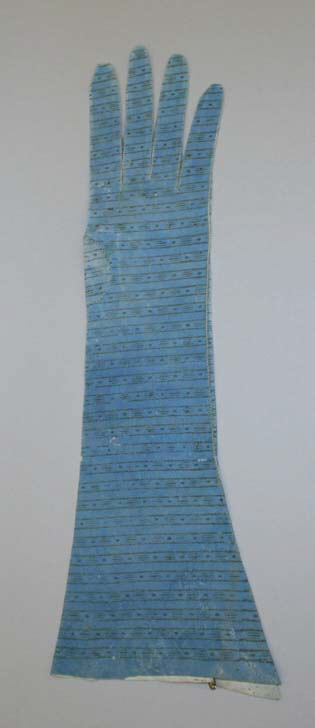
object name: glove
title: Gloves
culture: italian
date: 1767-1833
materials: leather